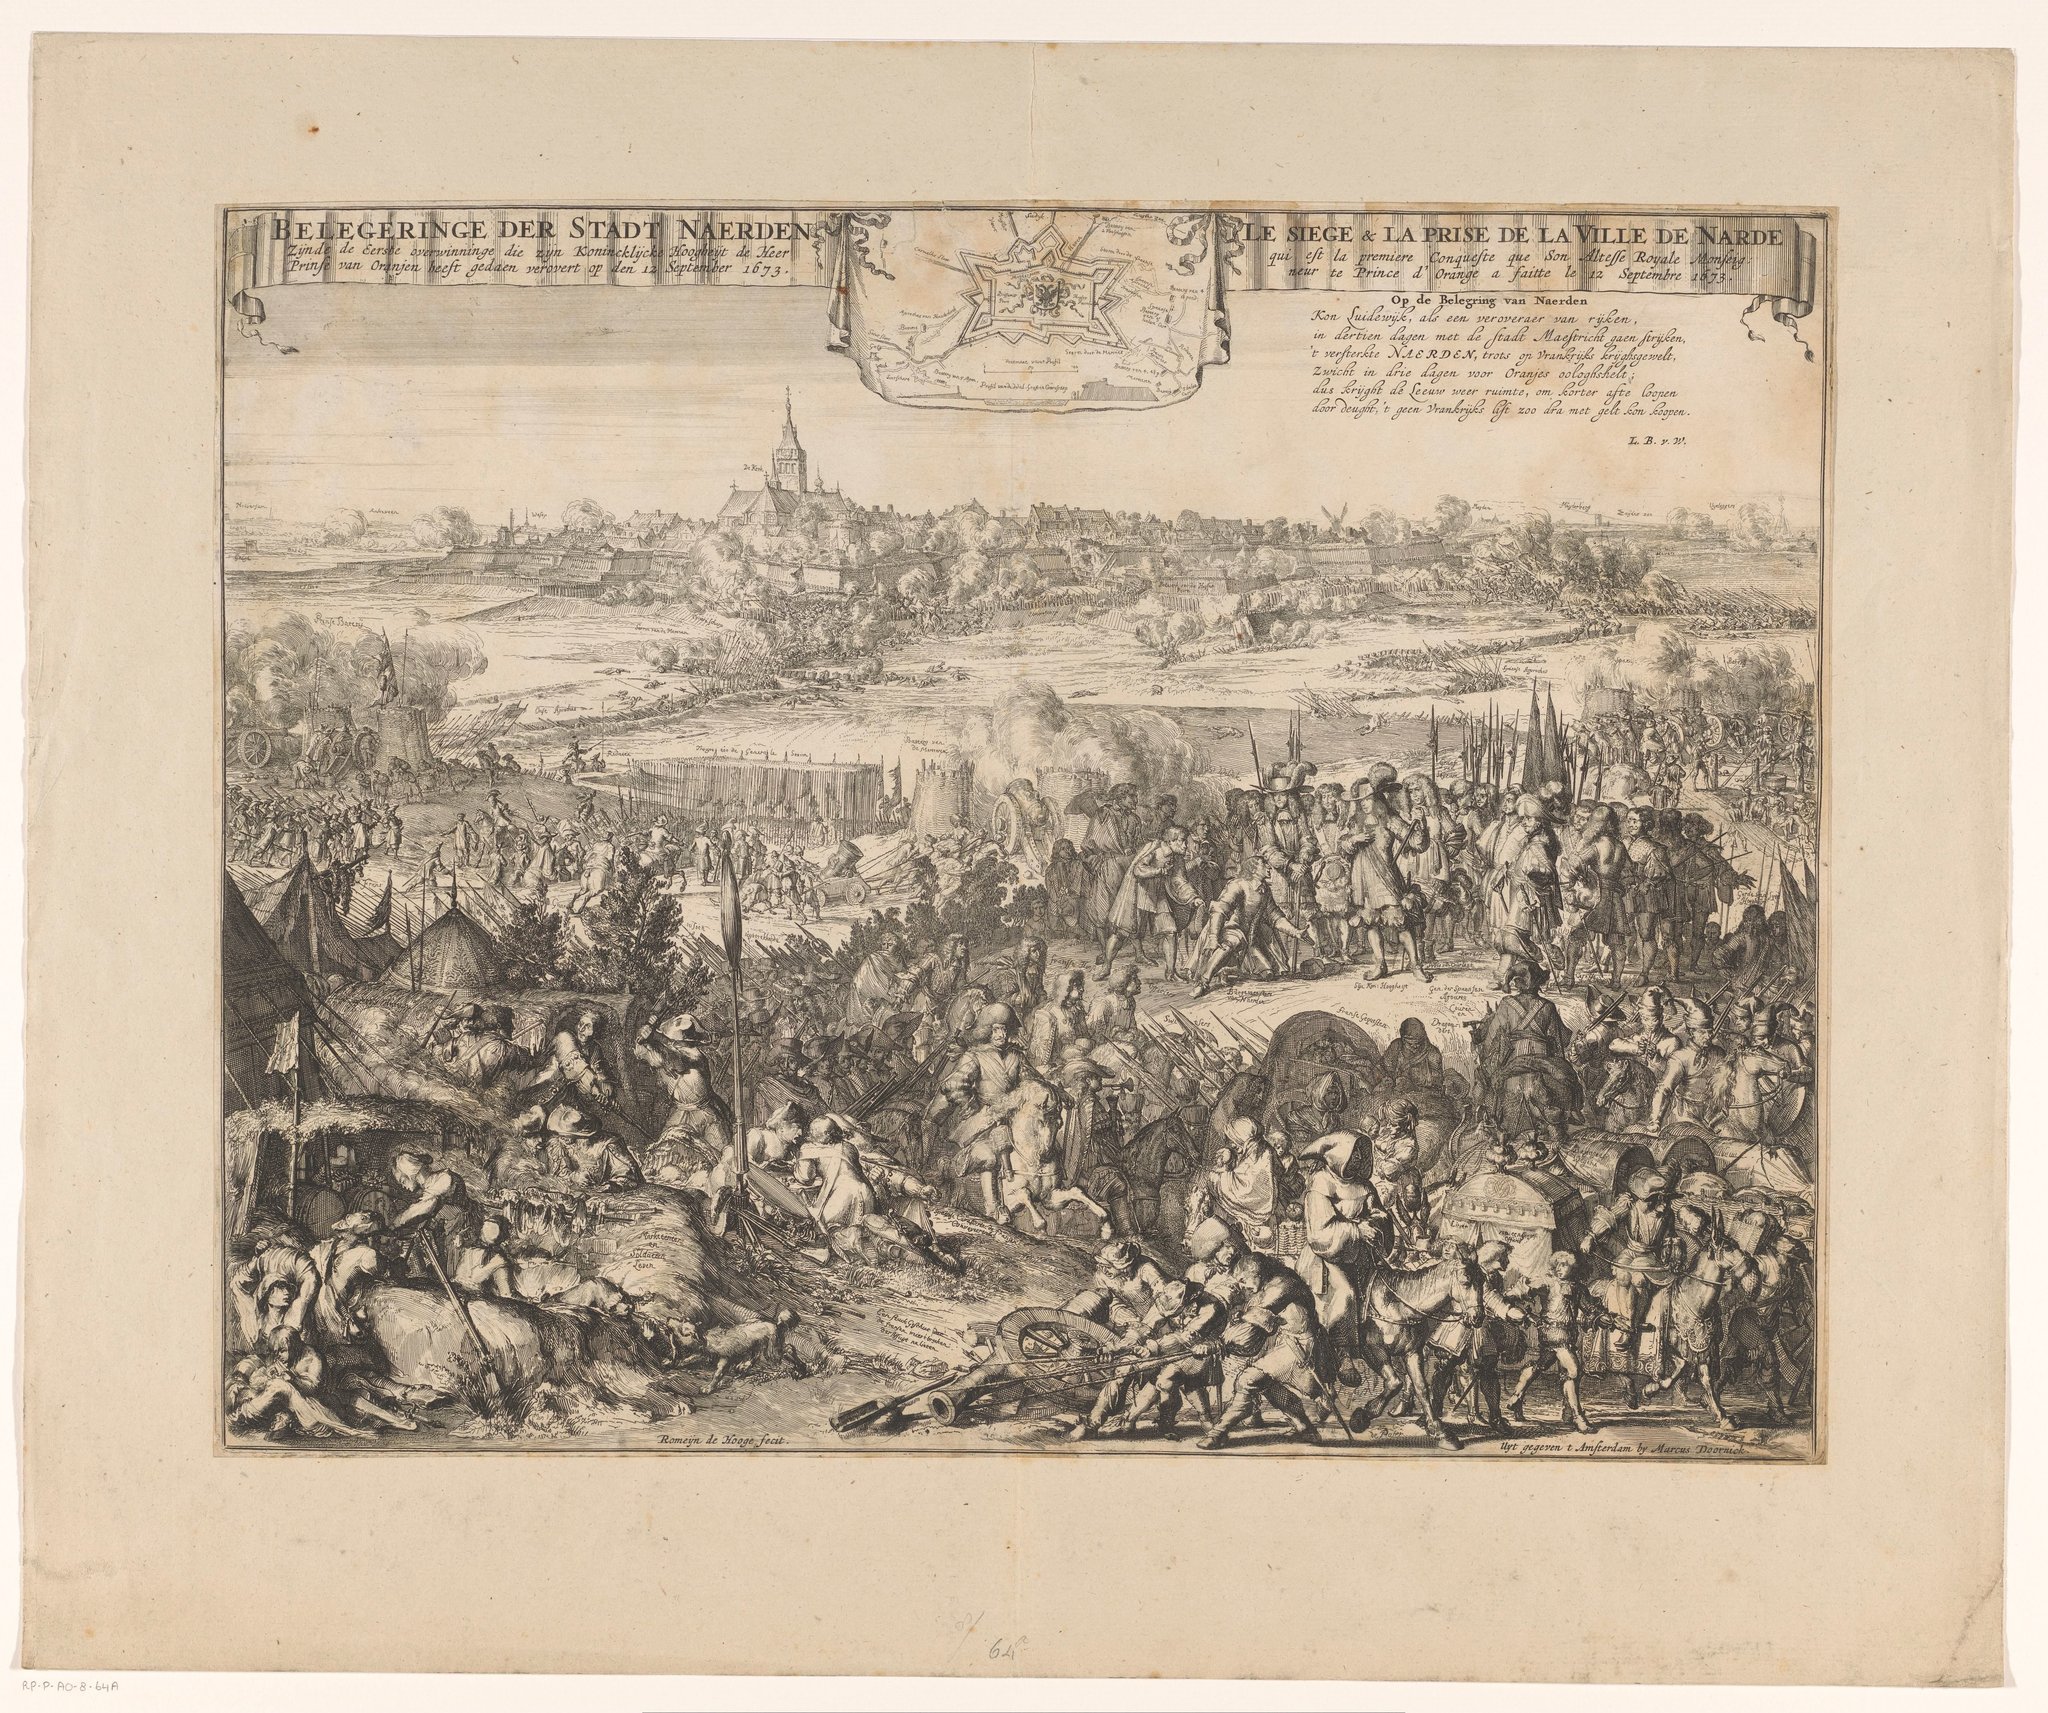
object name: print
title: Belegeringe der stadt Naerden. Zijnde de eerste overwinninge die zijn Konincklijcke Hoogheijt de Heer Prinse van Oranjen heeft gedaen verovert op den 12 september 1673 / Le siege & la prise de la ville de Narde qui est la premiere conqueste que Son Altesse Royale Monseigneur le Prince d'Orange a faitte le 12 septembre 1673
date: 1673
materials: paper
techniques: engraving, etching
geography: amsterdam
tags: the hague, william iii (prince of orange and king of england, scotland, and ireland), siege, position war, capture of city (after the siege)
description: Belegering en verovering van Naarden door de prins van Oranje, 12 september 1673. Op de voorgrond scènes uit het soldatenleven in het legerkamp. In het midden knielt de burgemeester van Naarden voor de prins die wordt omringd door zijn staf van officieren. In de verte het beleg en de bestorming van de stad. Bovenaan op een opgehangen doek een kaartje van de stad en de posities van de belegeraars, hiernaast een vers 'Op de Belegering van Naerden' in zes regels. Met meerdere opschriften in de voorstelling.